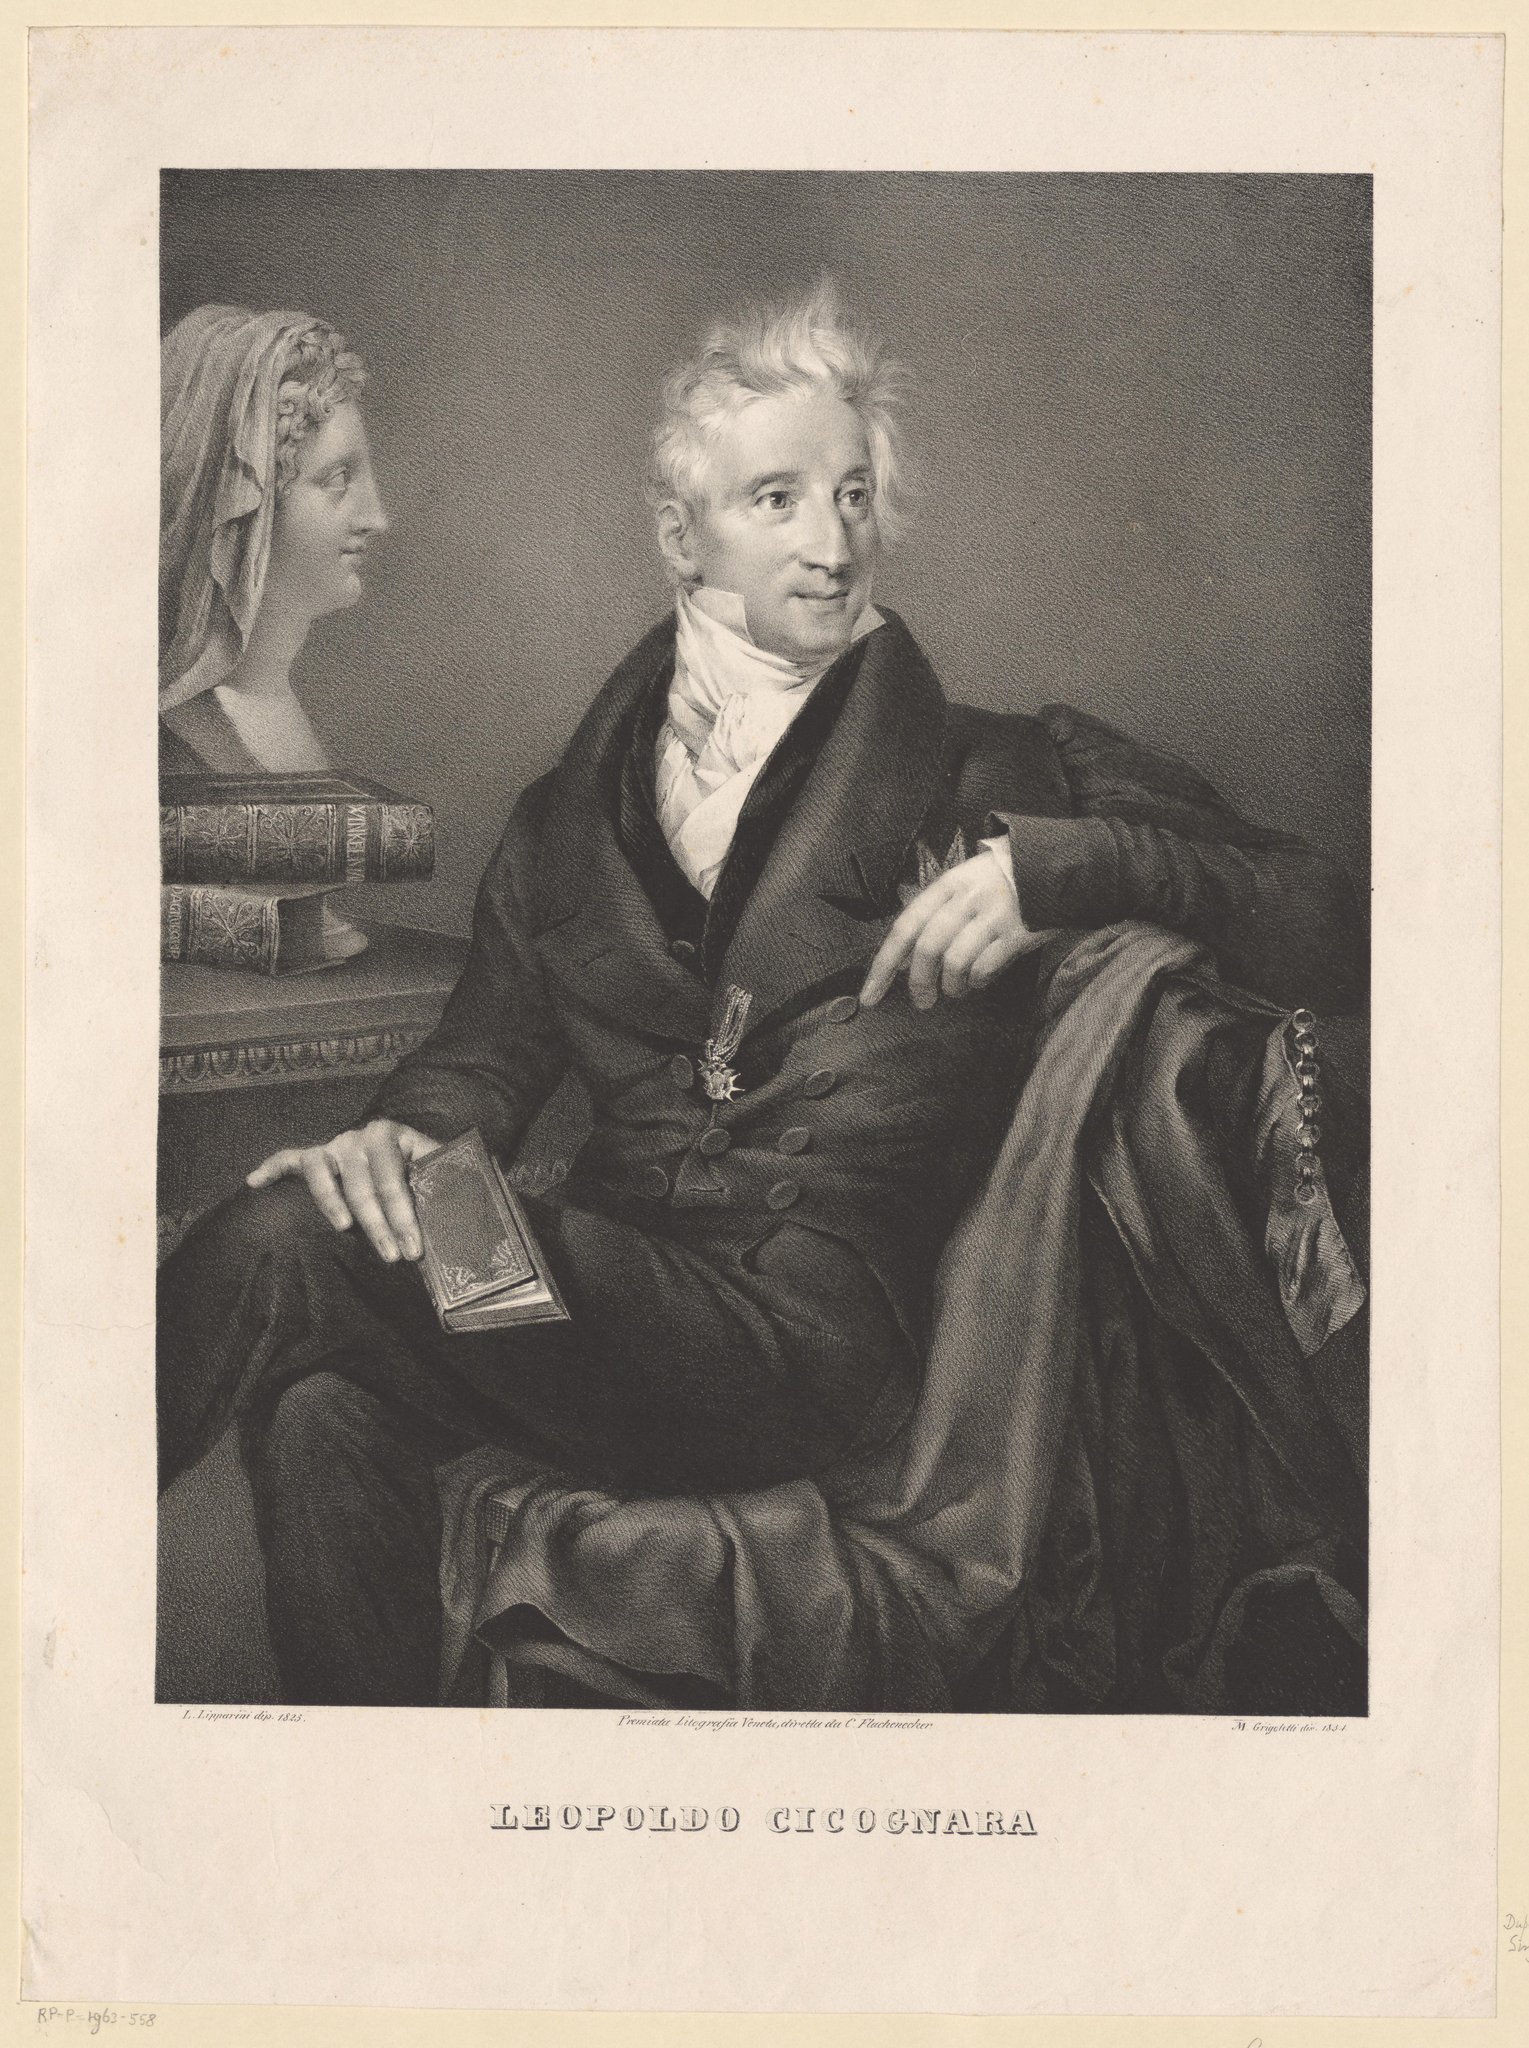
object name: print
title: Portret van Leopoldo Cicognara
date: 1834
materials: paper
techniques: lithograph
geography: venice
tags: venice, leopoldo cicognara, historical persons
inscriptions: collector's mark: Lugt 2228